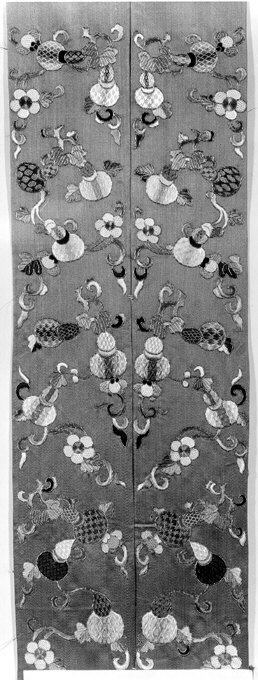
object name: sleeve band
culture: chinese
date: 1801-1900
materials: metal thread, silk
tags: flowers